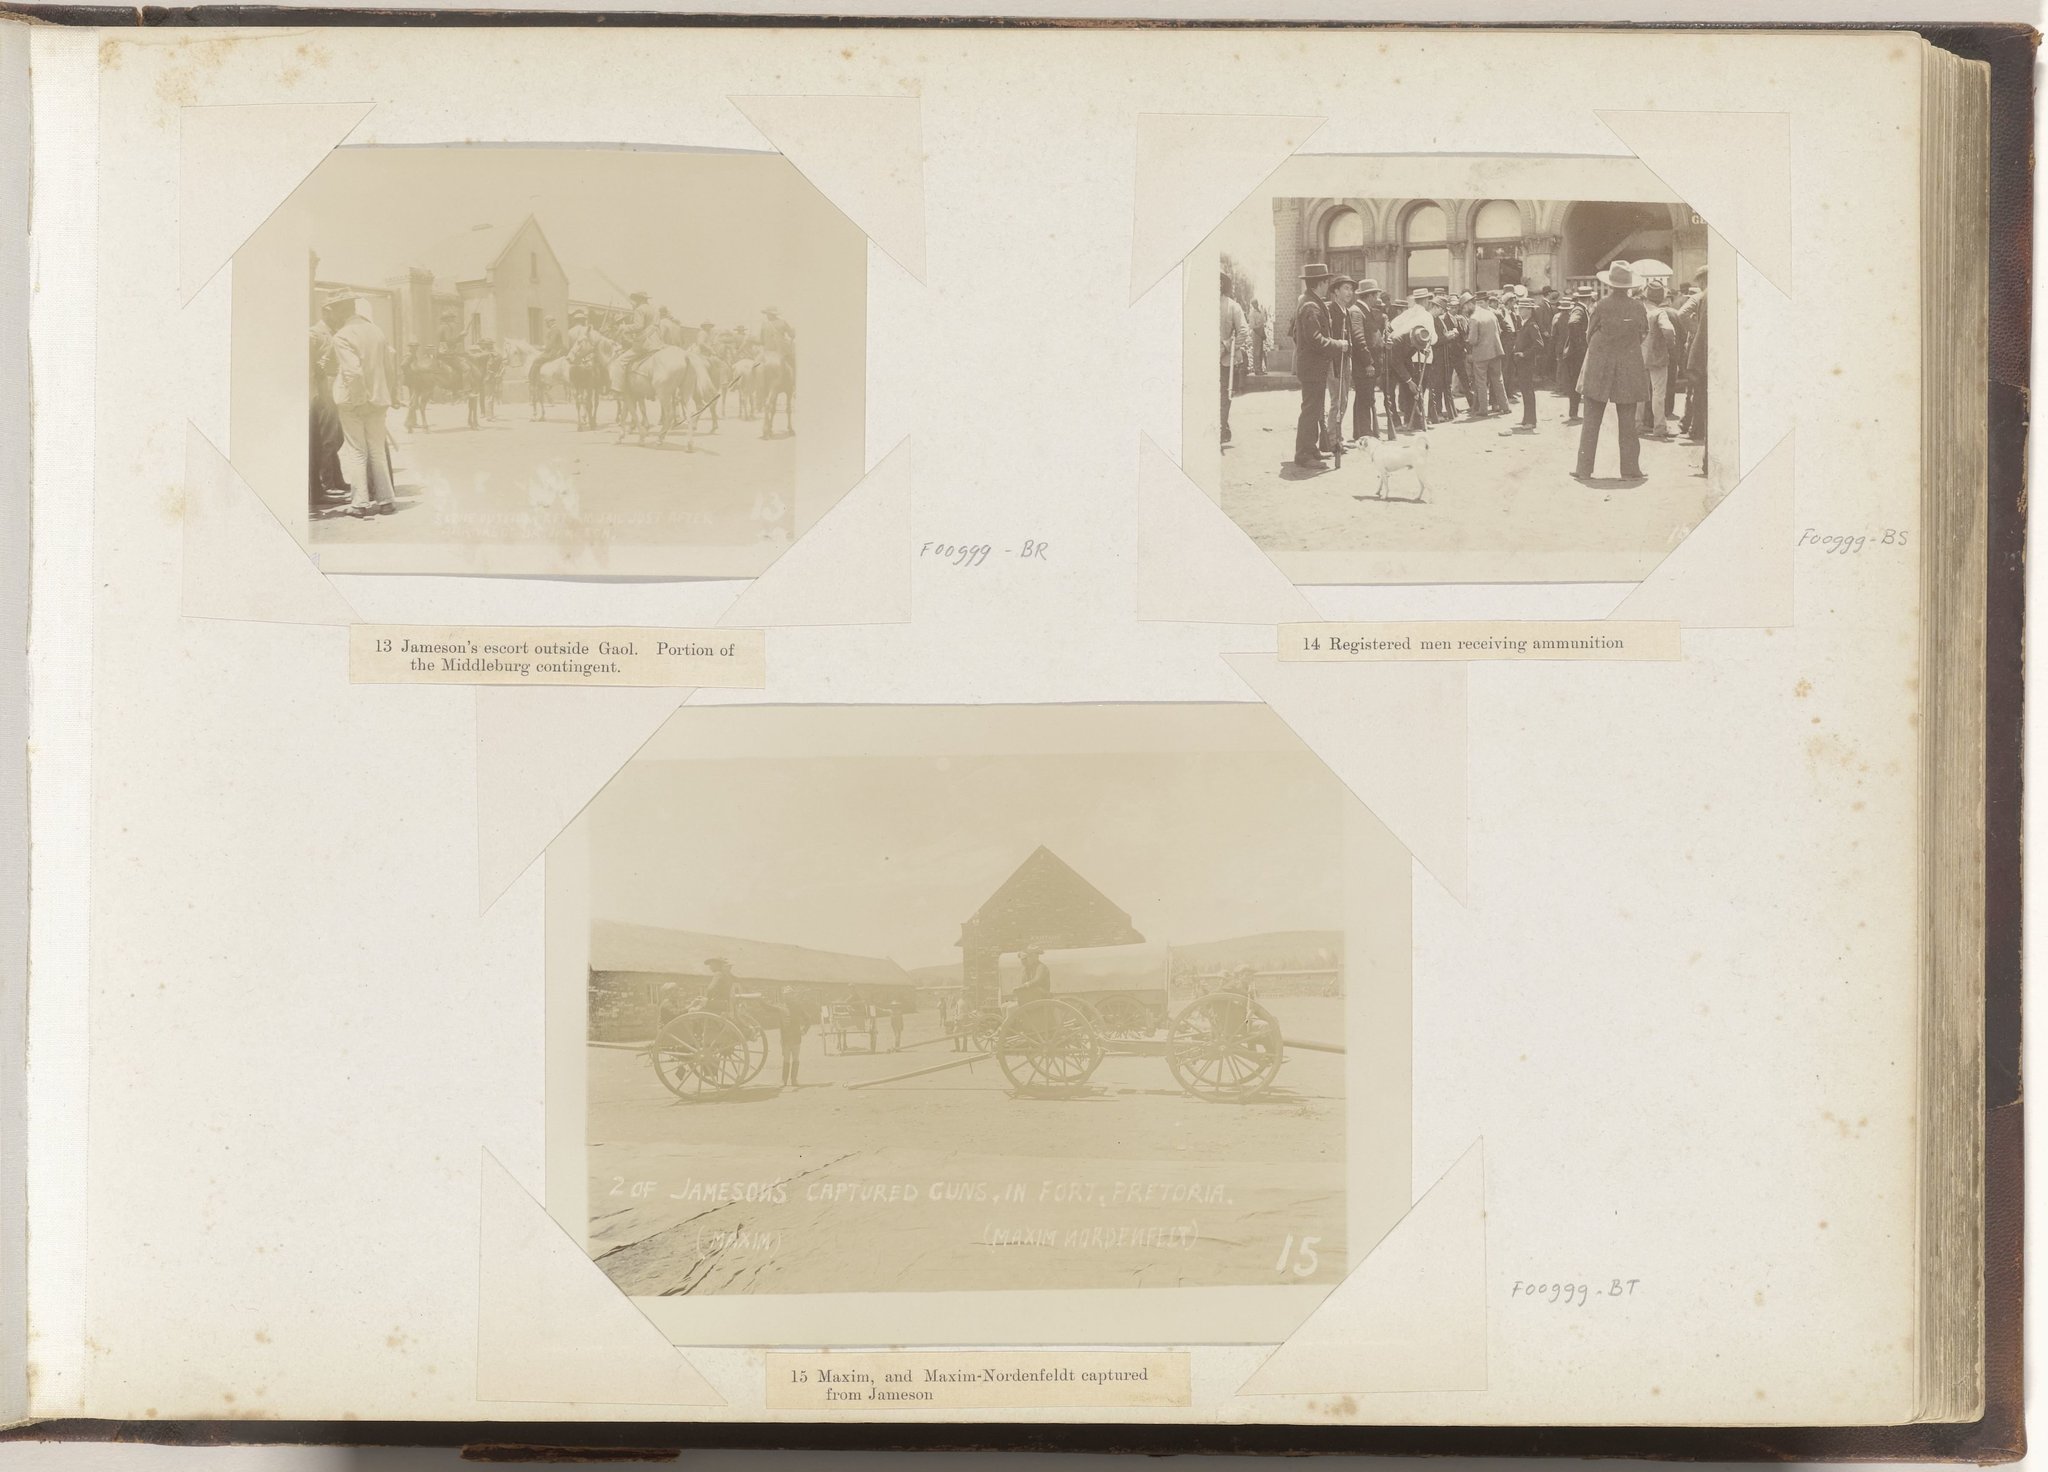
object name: photograph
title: 14 Registered men receiving ammunition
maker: Anonymous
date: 1896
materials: paper, photographic support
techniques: gelatin silver print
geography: south africa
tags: ammunition store, arsenal, street (+ city(-scape) with figures, staffage)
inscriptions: number: ‘14’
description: Onderdeel van Album met 191 foto's van een reis naar en door Zuid-Afrika.